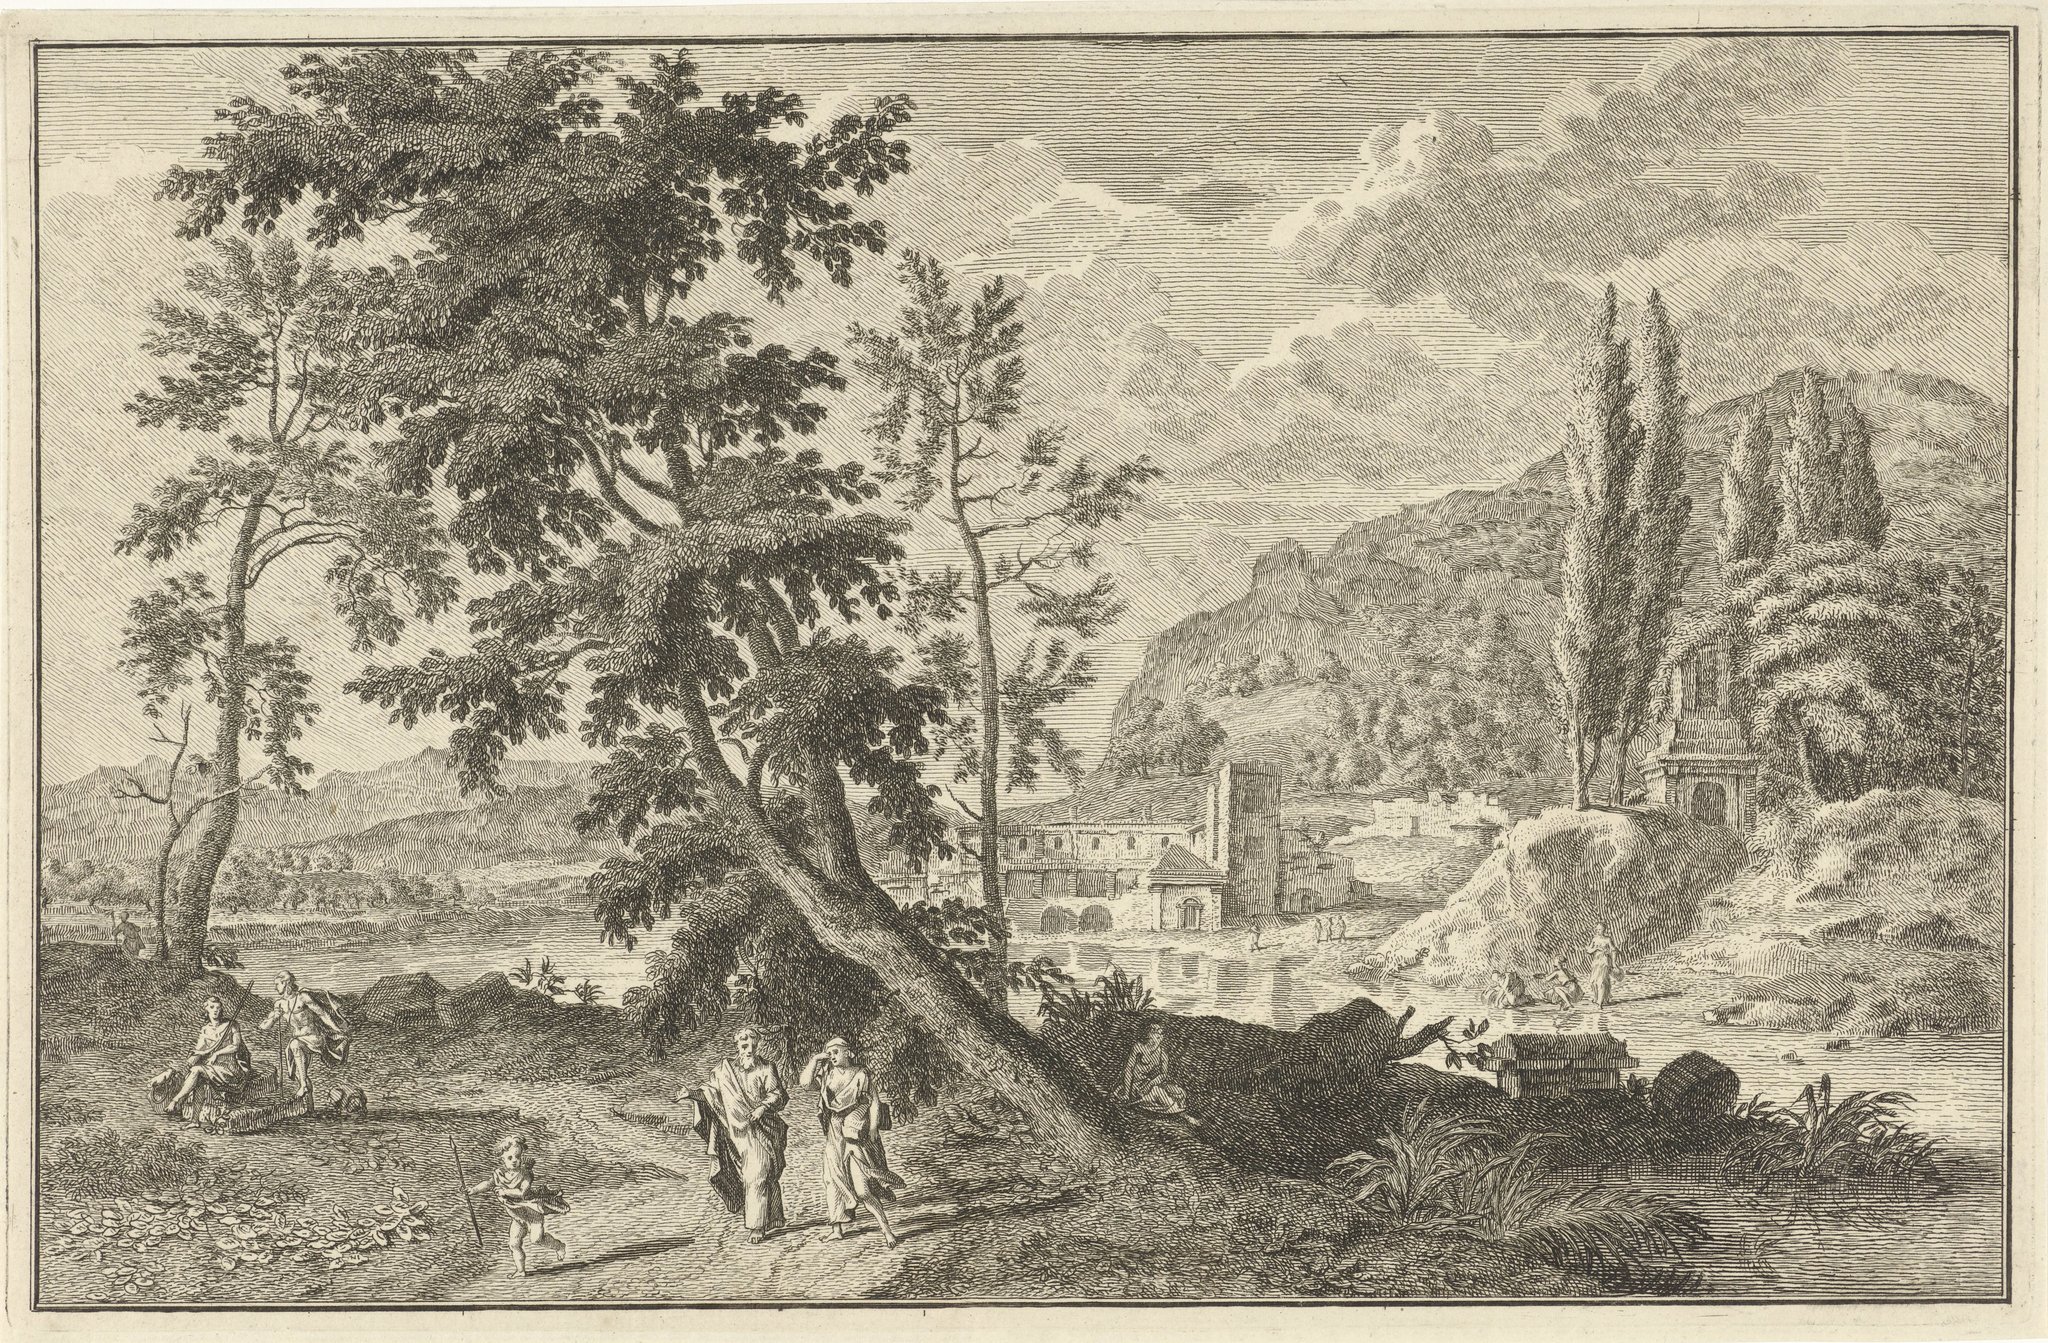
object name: print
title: Italiaanse en Duitse landschappen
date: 1710-1747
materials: paper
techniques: etching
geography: amsterdam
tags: landscapes with waters, waterscapes, seascapes (in the temperate zone), cupids: 'amores', 'amoretti', 'putti'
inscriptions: collector's mark: Lugt 240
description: Landschap met rivier, op de voorgrond een bebaarde en vrouw, voor hen uit rennend een putto. Geheel links twee jagers. De prent maakt deel uit van een 40-delige serie prenten met voorstellingen van Italiaanse en Duitse landschappen.